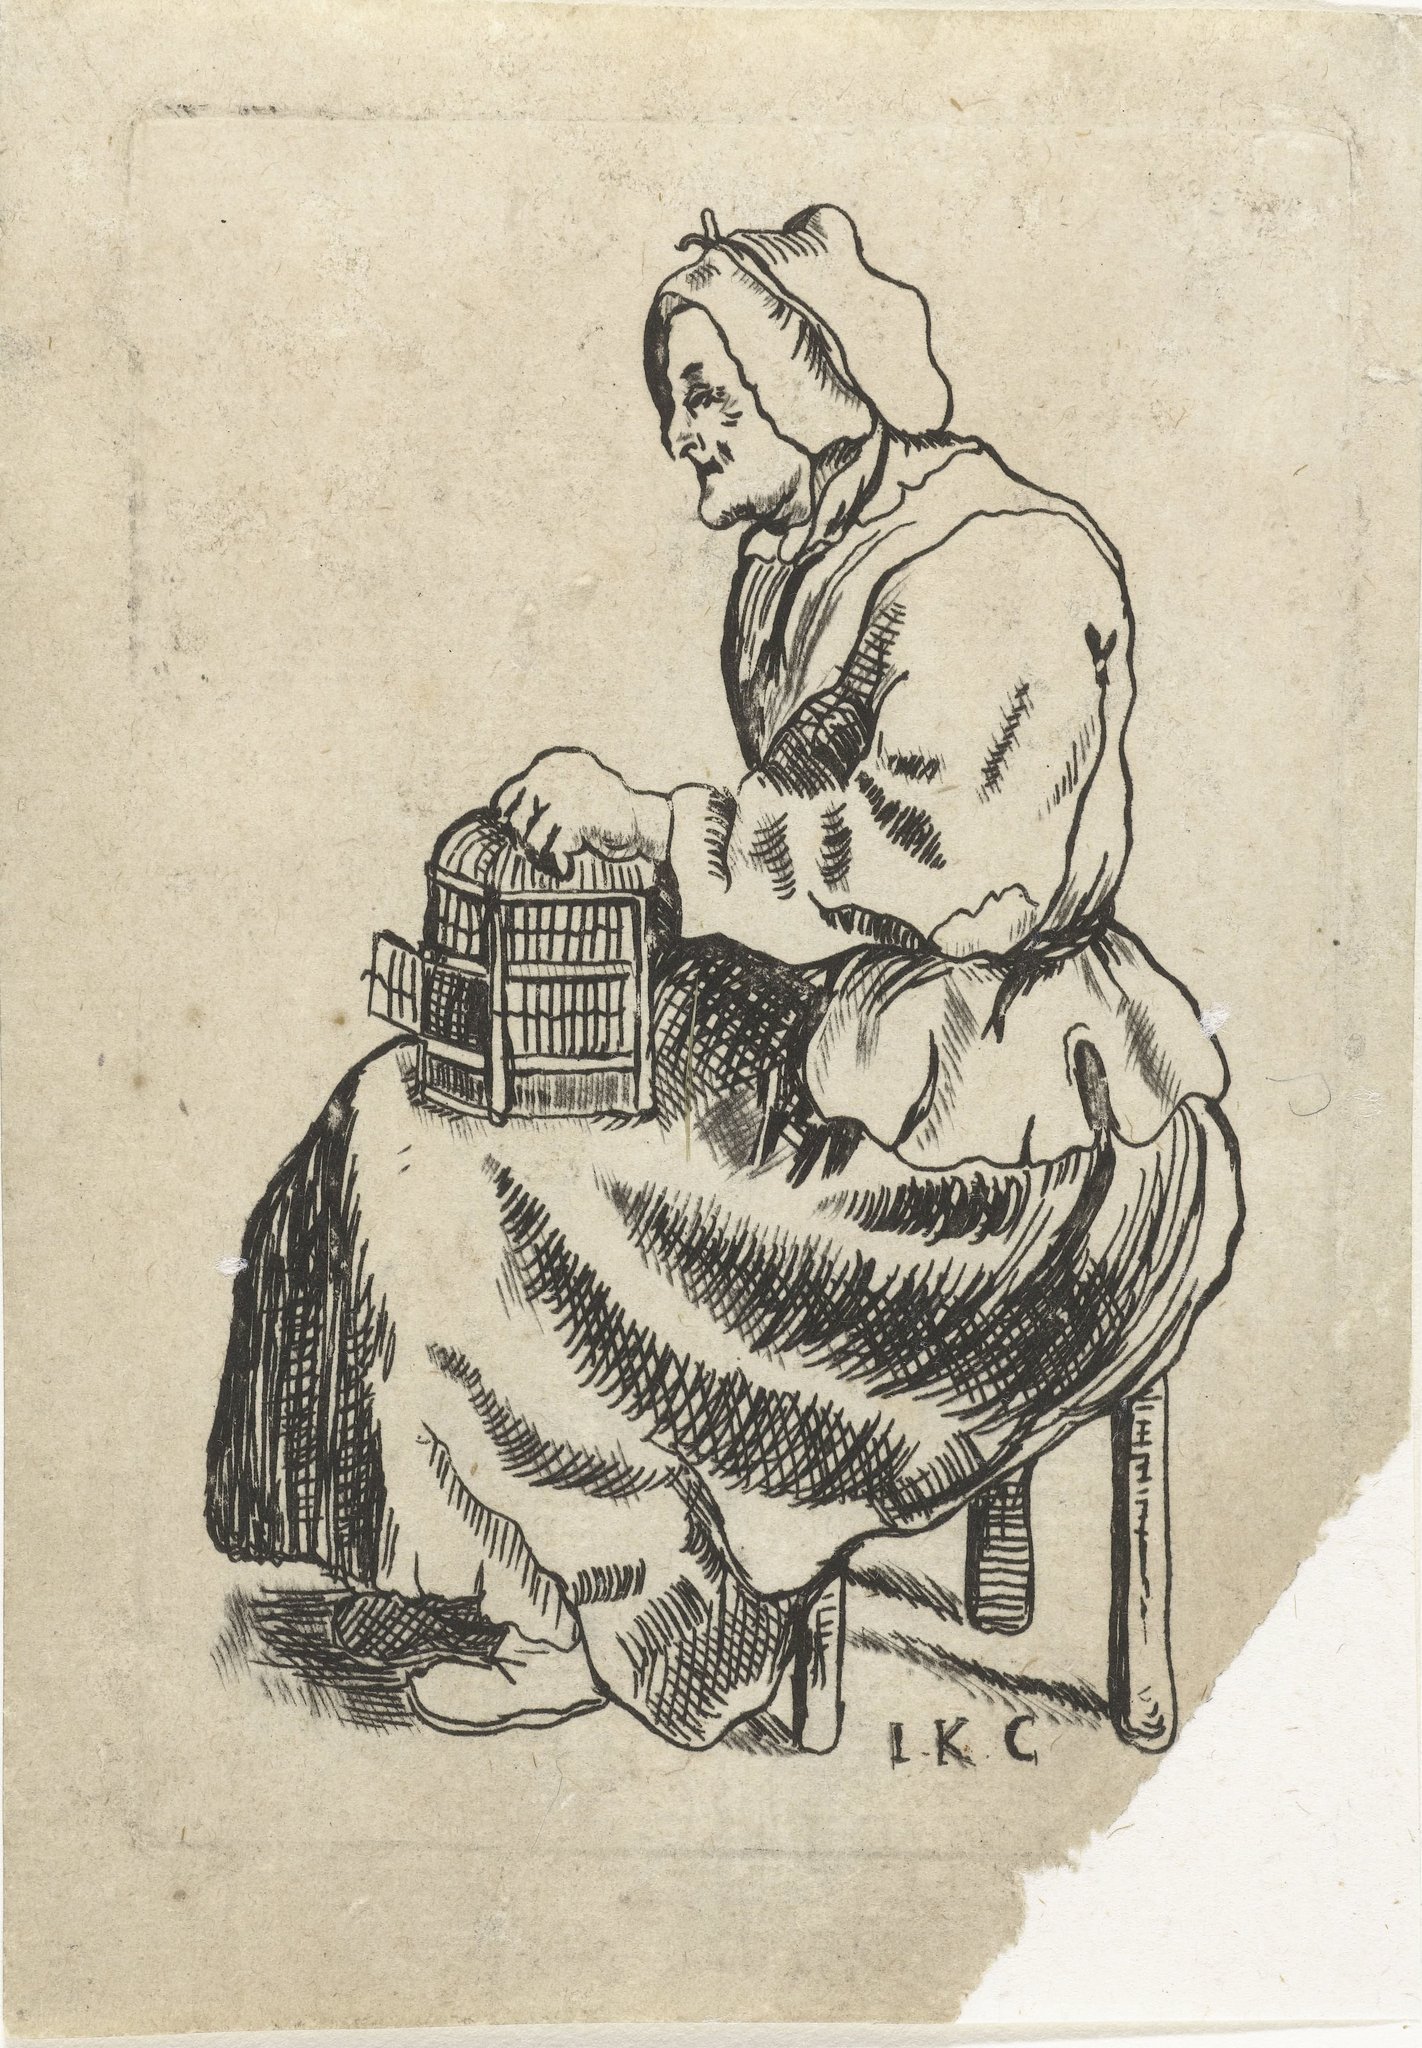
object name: print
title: Oude vrouw met open vogelkooi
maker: johan antoni kauclitz colizzi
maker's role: print maker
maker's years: 1742-1808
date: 1774-1808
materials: paper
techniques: etching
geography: netherlands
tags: old woman, bird-cage opened (loss of virginity symbolized)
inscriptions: collector's mark: Lugt 2233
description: Een oude vrouw zit op een stoel, op haar schoot een geopende vogelkooi.